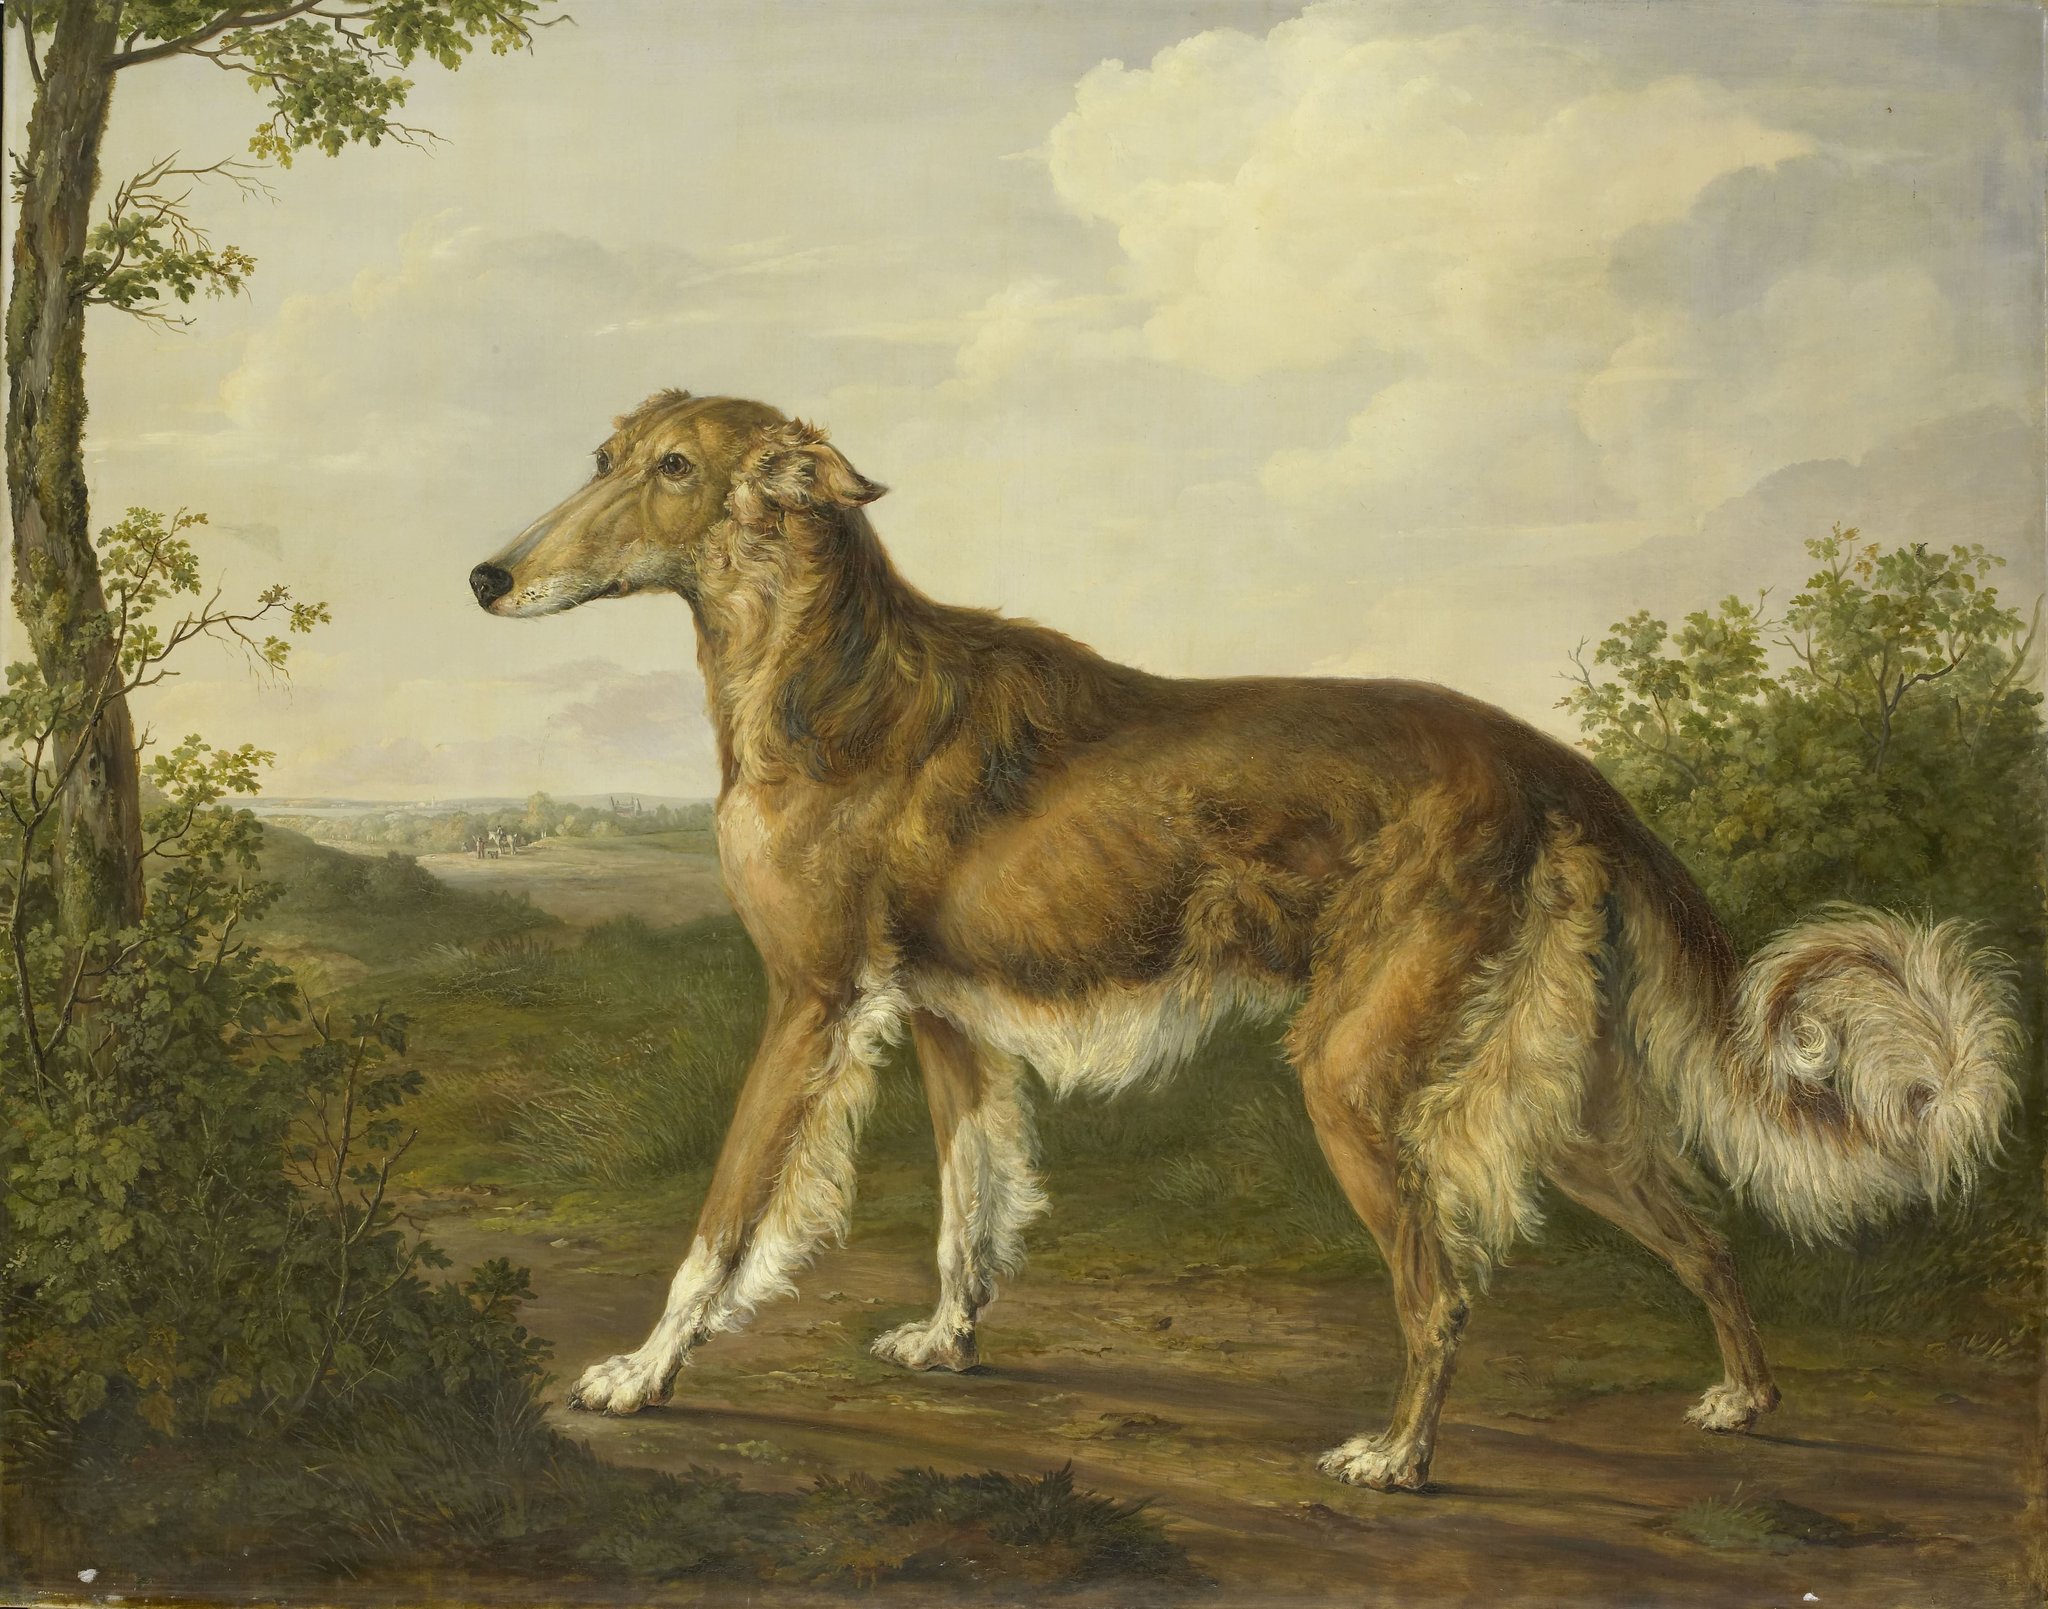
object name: painting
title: Siberian Greyhound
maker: jan dasveldt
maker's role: draughtsman, print maker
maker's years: 1770-1855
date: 1825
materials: canvas, oil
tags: dog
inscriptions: signature: ‘J. Dasveldt’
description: Siberische windhond, staande op een pad in een landschap.